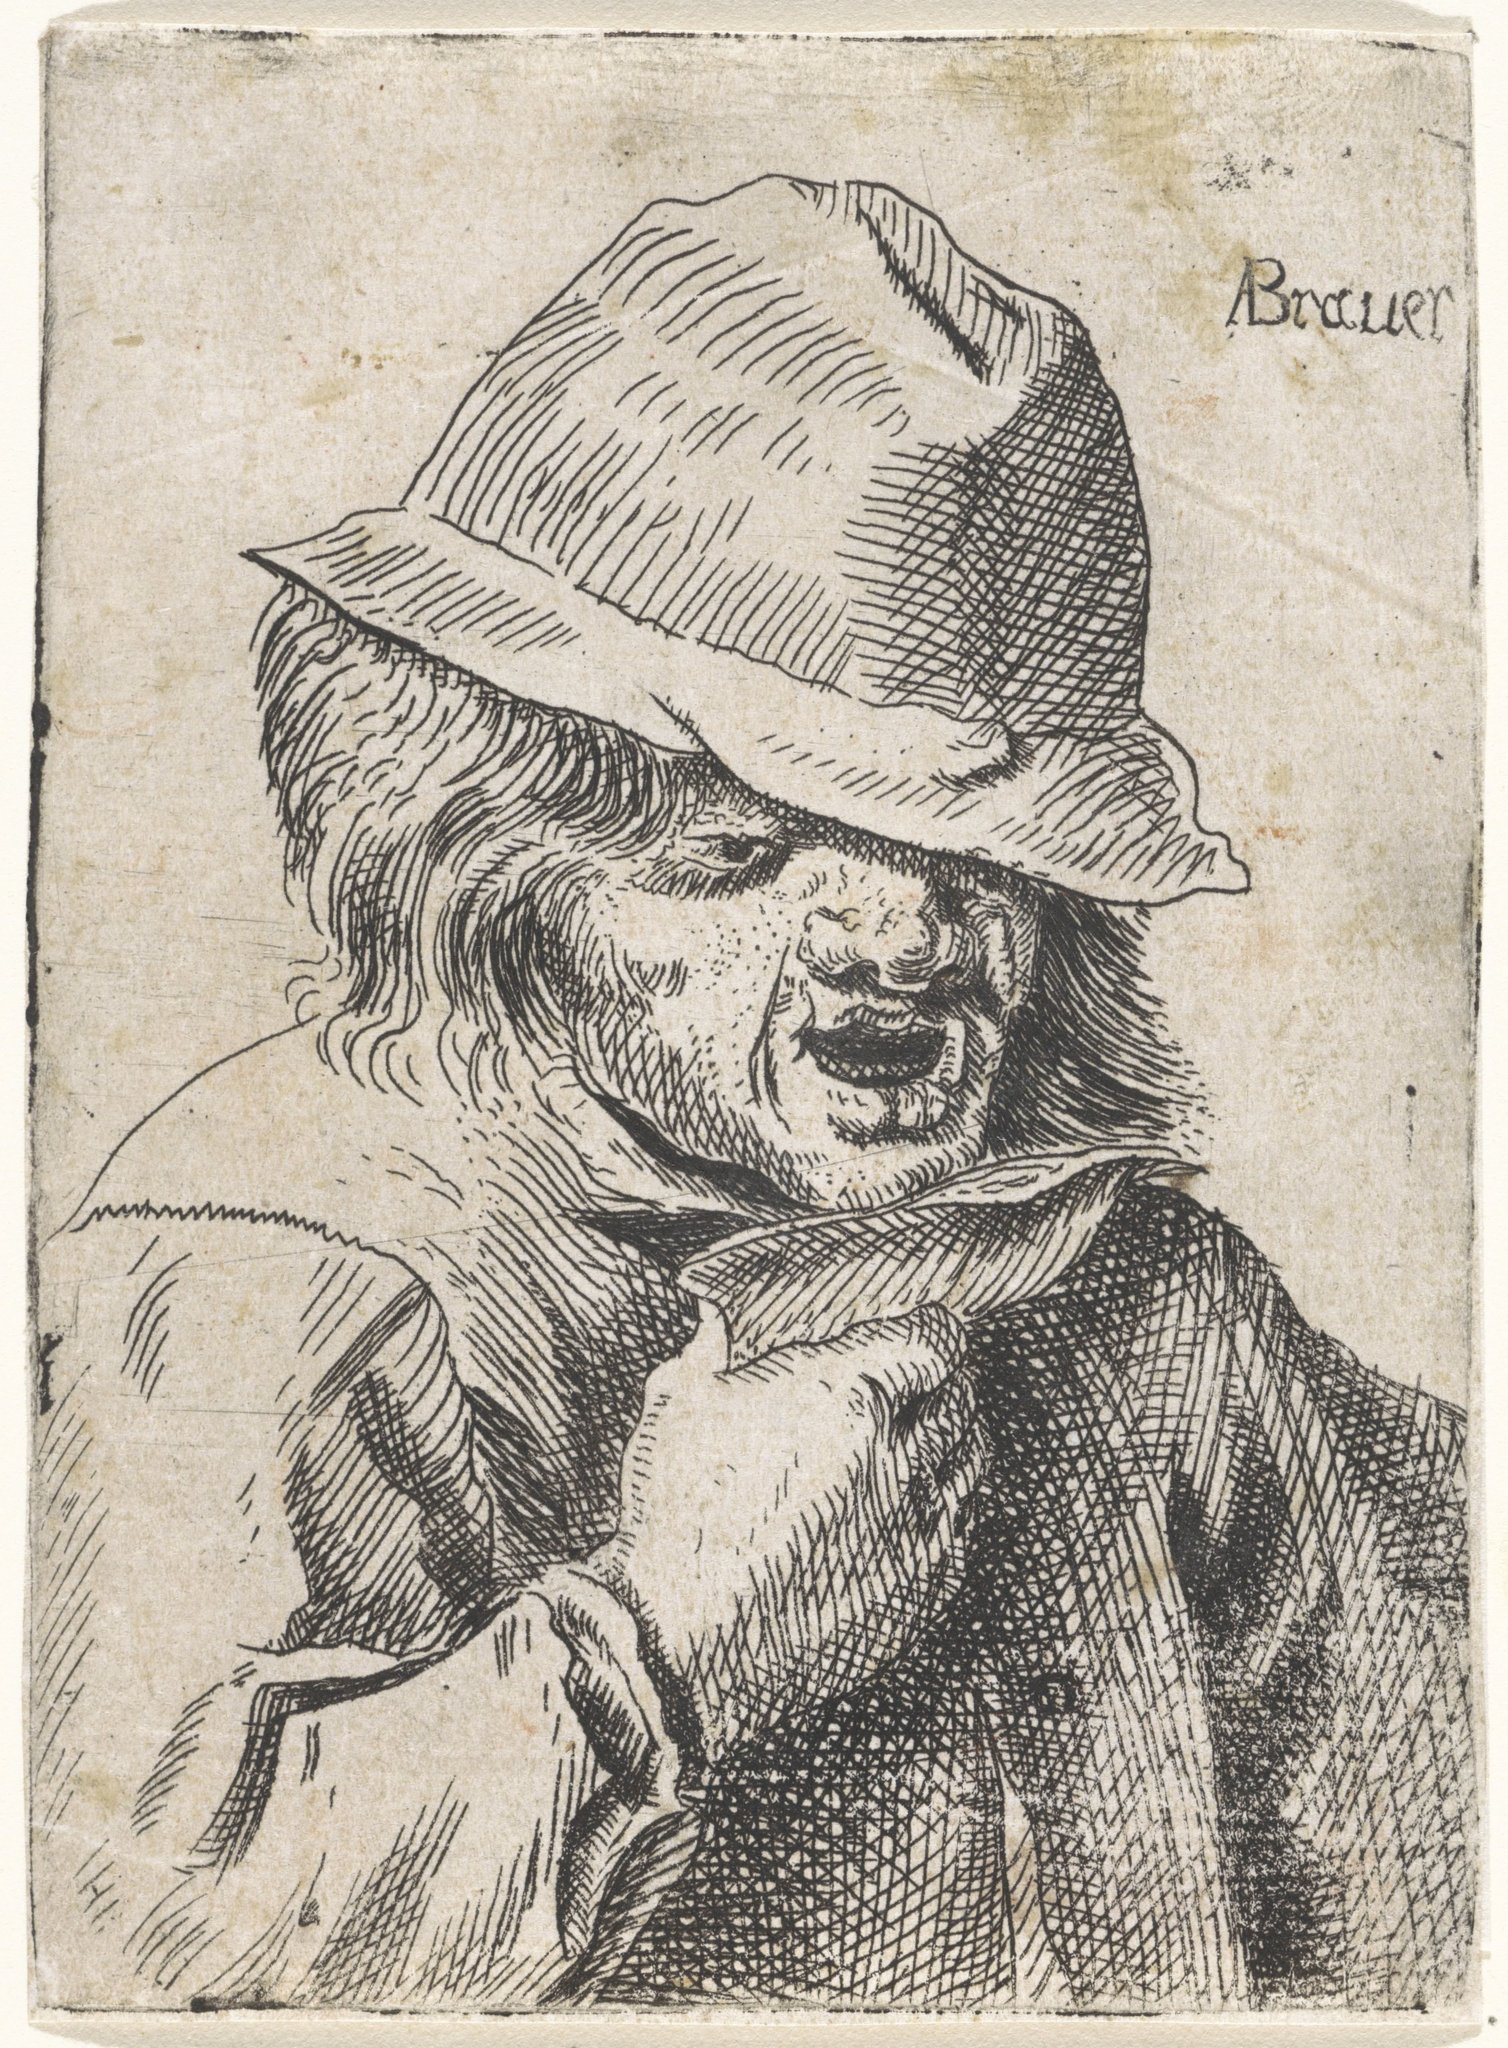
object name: print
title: Boer met een drinknap in zijn hand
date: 1622-1688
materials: paper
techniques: etching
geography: low countries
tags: farmers, drinking-vessels, drinking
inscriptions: collector's mark: Lugt 240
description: Een boer met een muts houdt een drinknap bij zijn geopende mond.